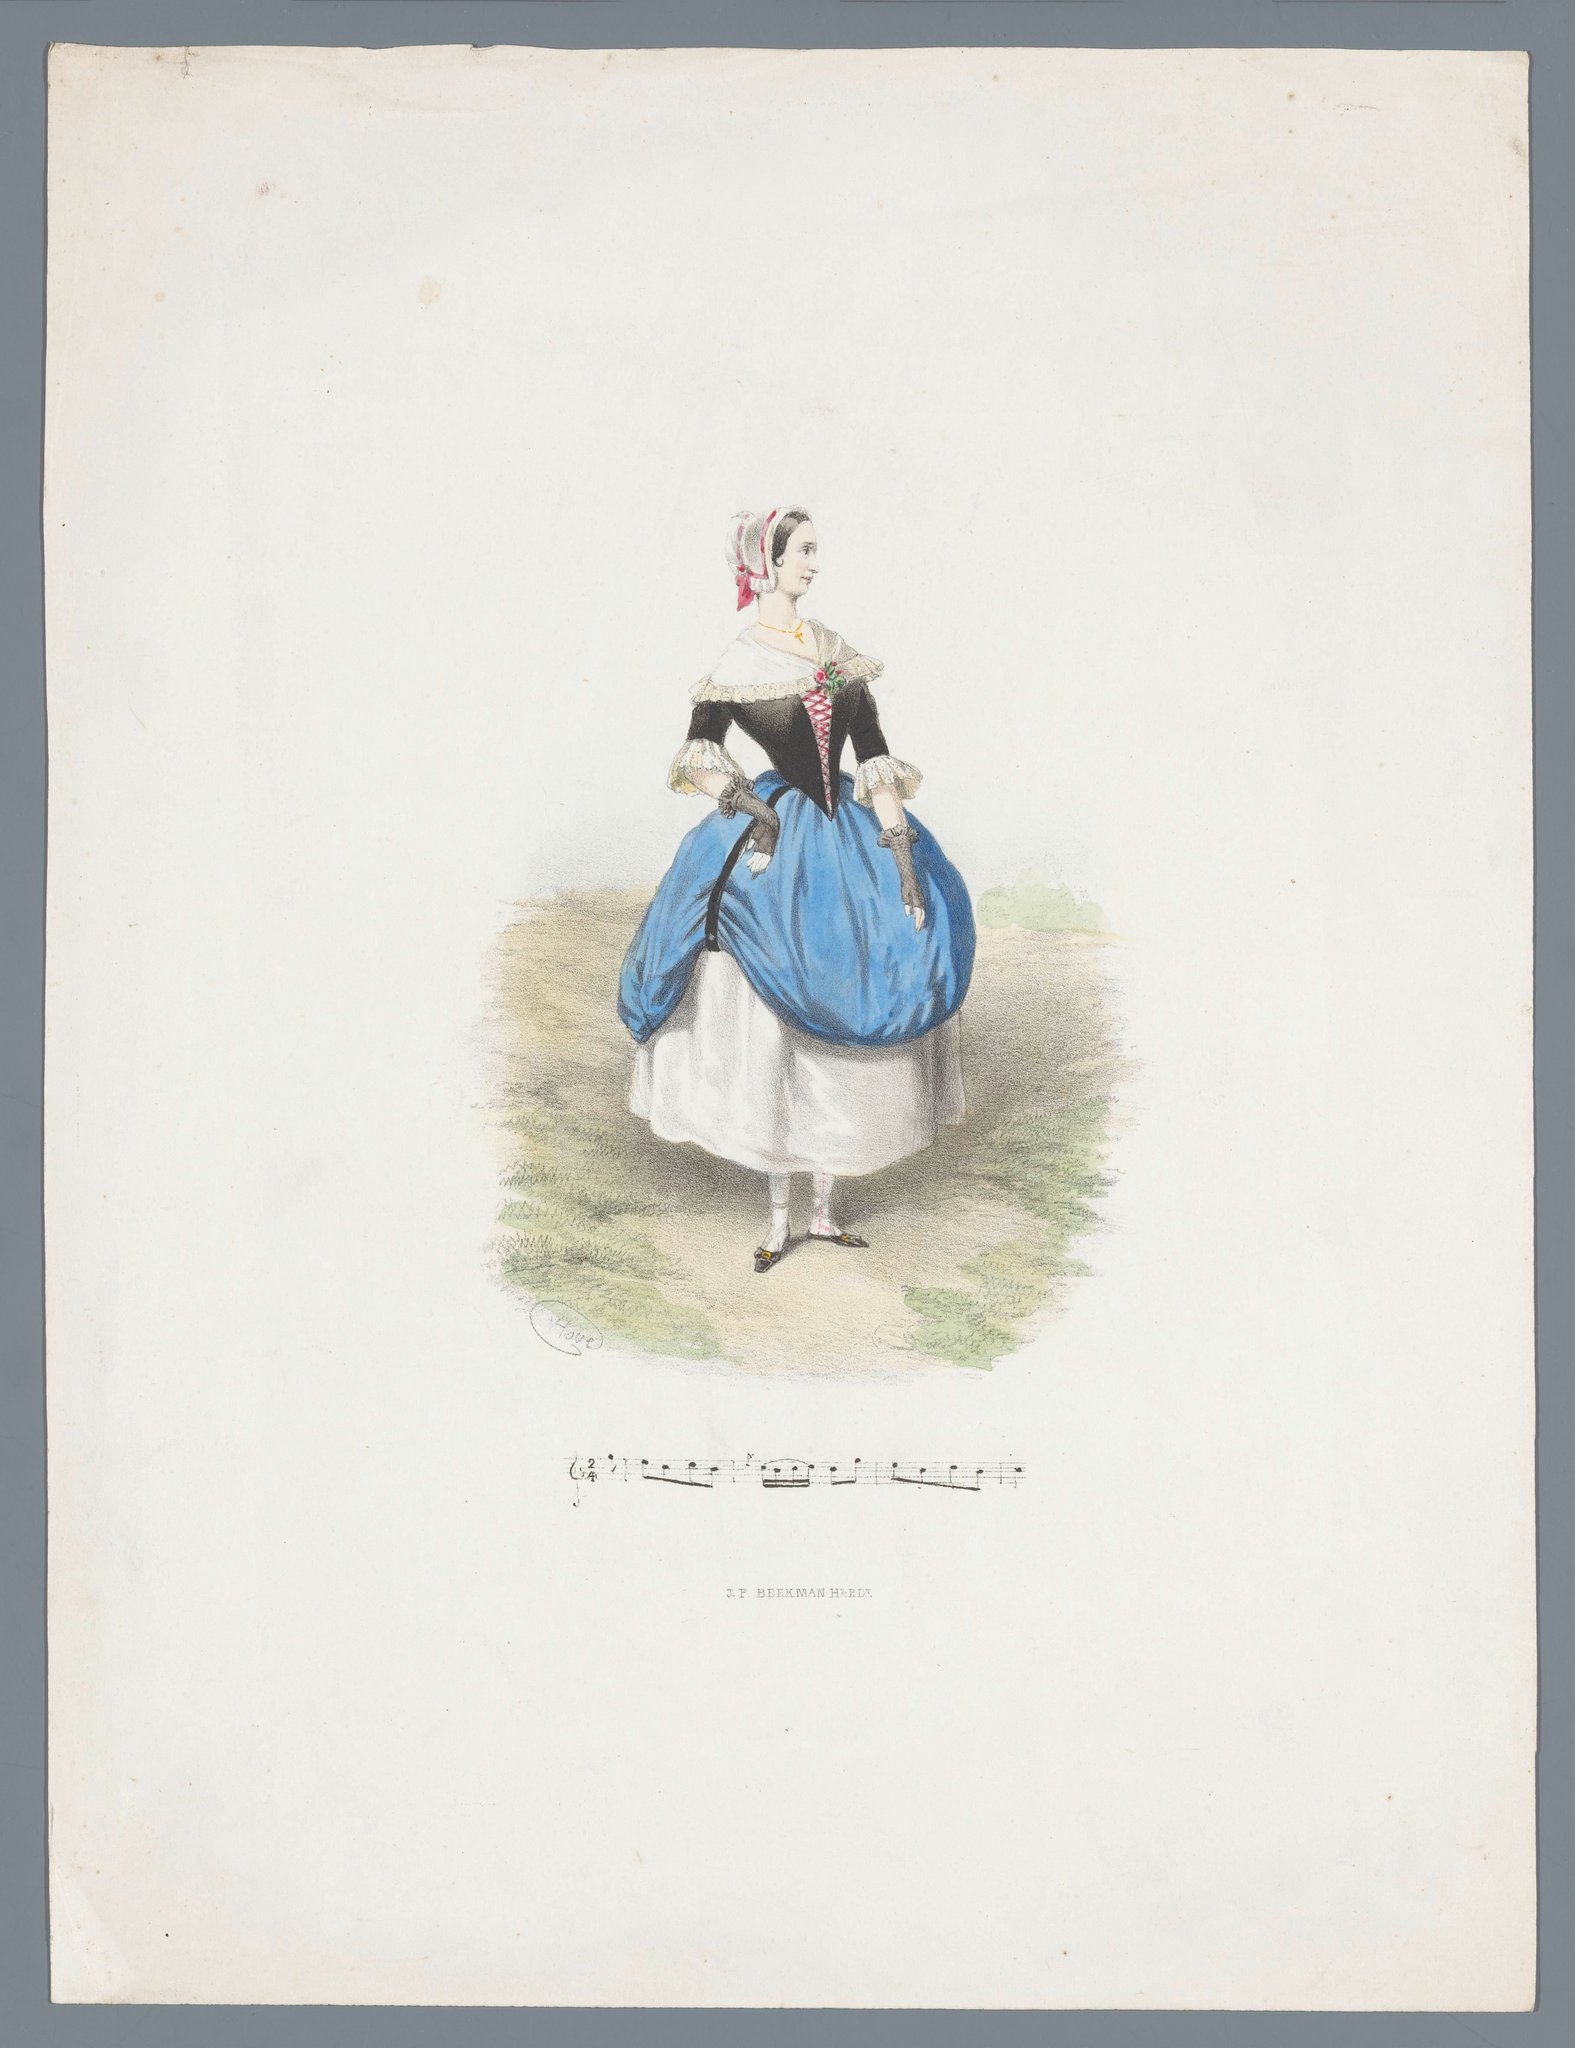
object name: costume print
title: Vrouw in historisch kostuum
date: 1841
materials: paper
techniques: hand coloring, lithograph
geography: netherlands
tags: anna paulowna romanowa, william ii of the netherlands, historical costume, the hague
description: Vrouw in historisch kostuum, als herderin of boerin. Onderaan muzieknoten. Kostuum gedragen op het gekostumeerde bal gehouden te Den Haag op 17 en 19 februari 1841 bij het 25-jarig huwelijk van koning Willem II en Anna Paulowna.